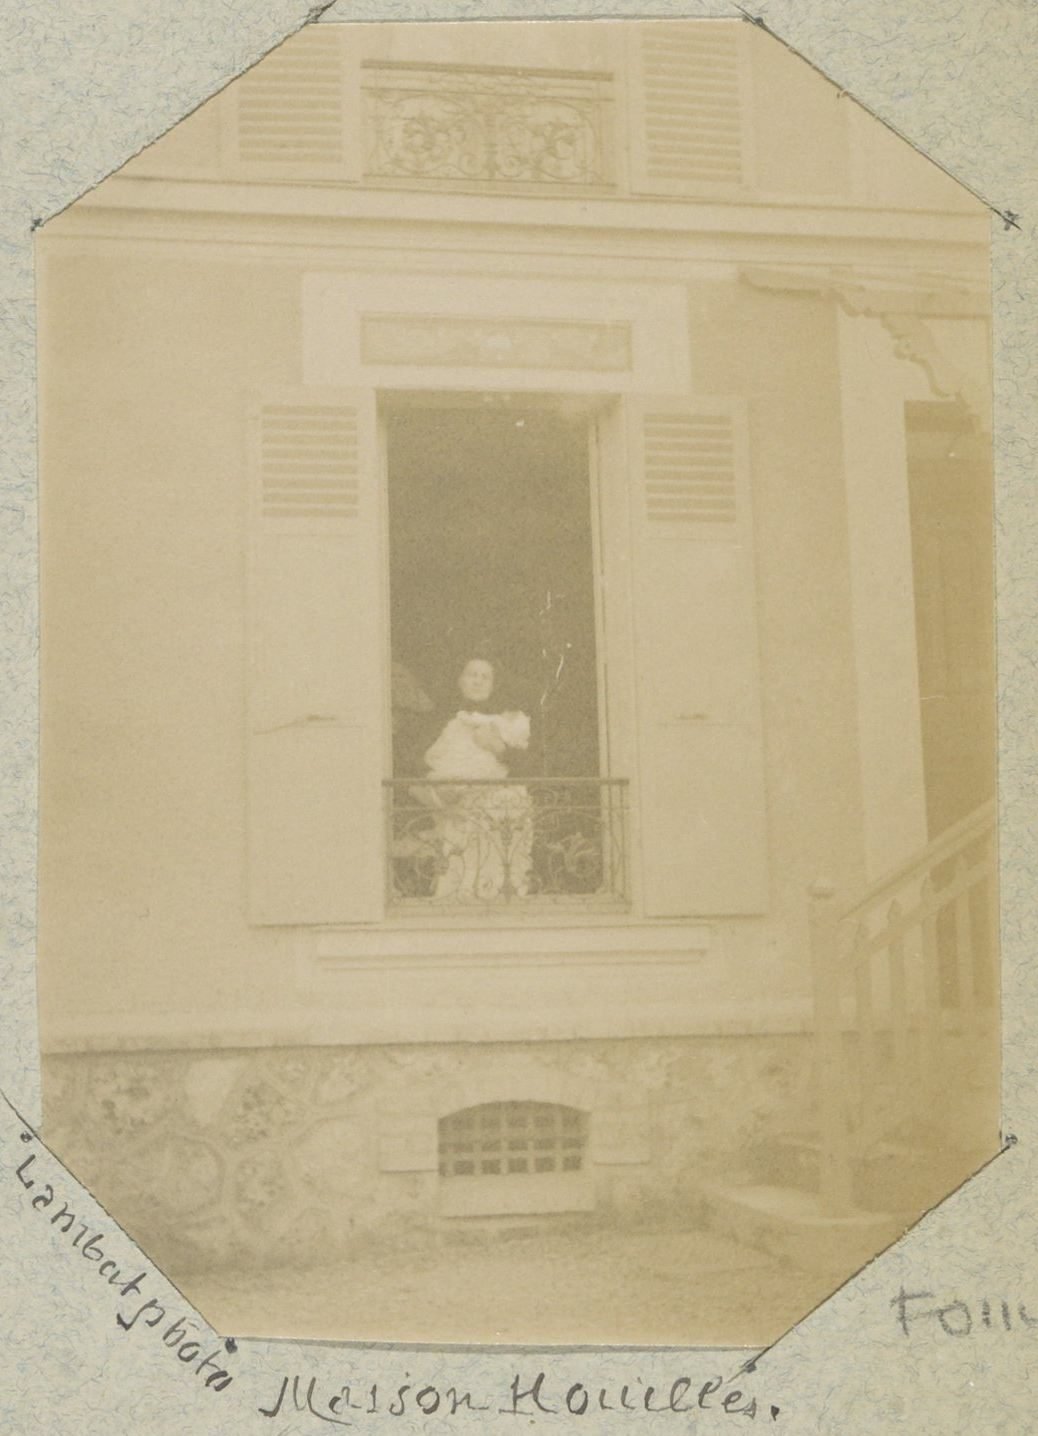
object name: photograph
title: Vrouw met een baby op de arm voor een raam, vermoedelijk in Houilles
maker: lambert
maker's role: painter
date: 1890-1900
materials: paper, photographic support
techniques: albumen print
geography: france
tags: window shutters on the outside, mother and baby or young child, france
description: Onderdeel van Album van een Franse amateur met foto's van Frankrijk, Algerije, Palmyra, de Wereldtentoonstelling van 1900 en van bekende Fransen.